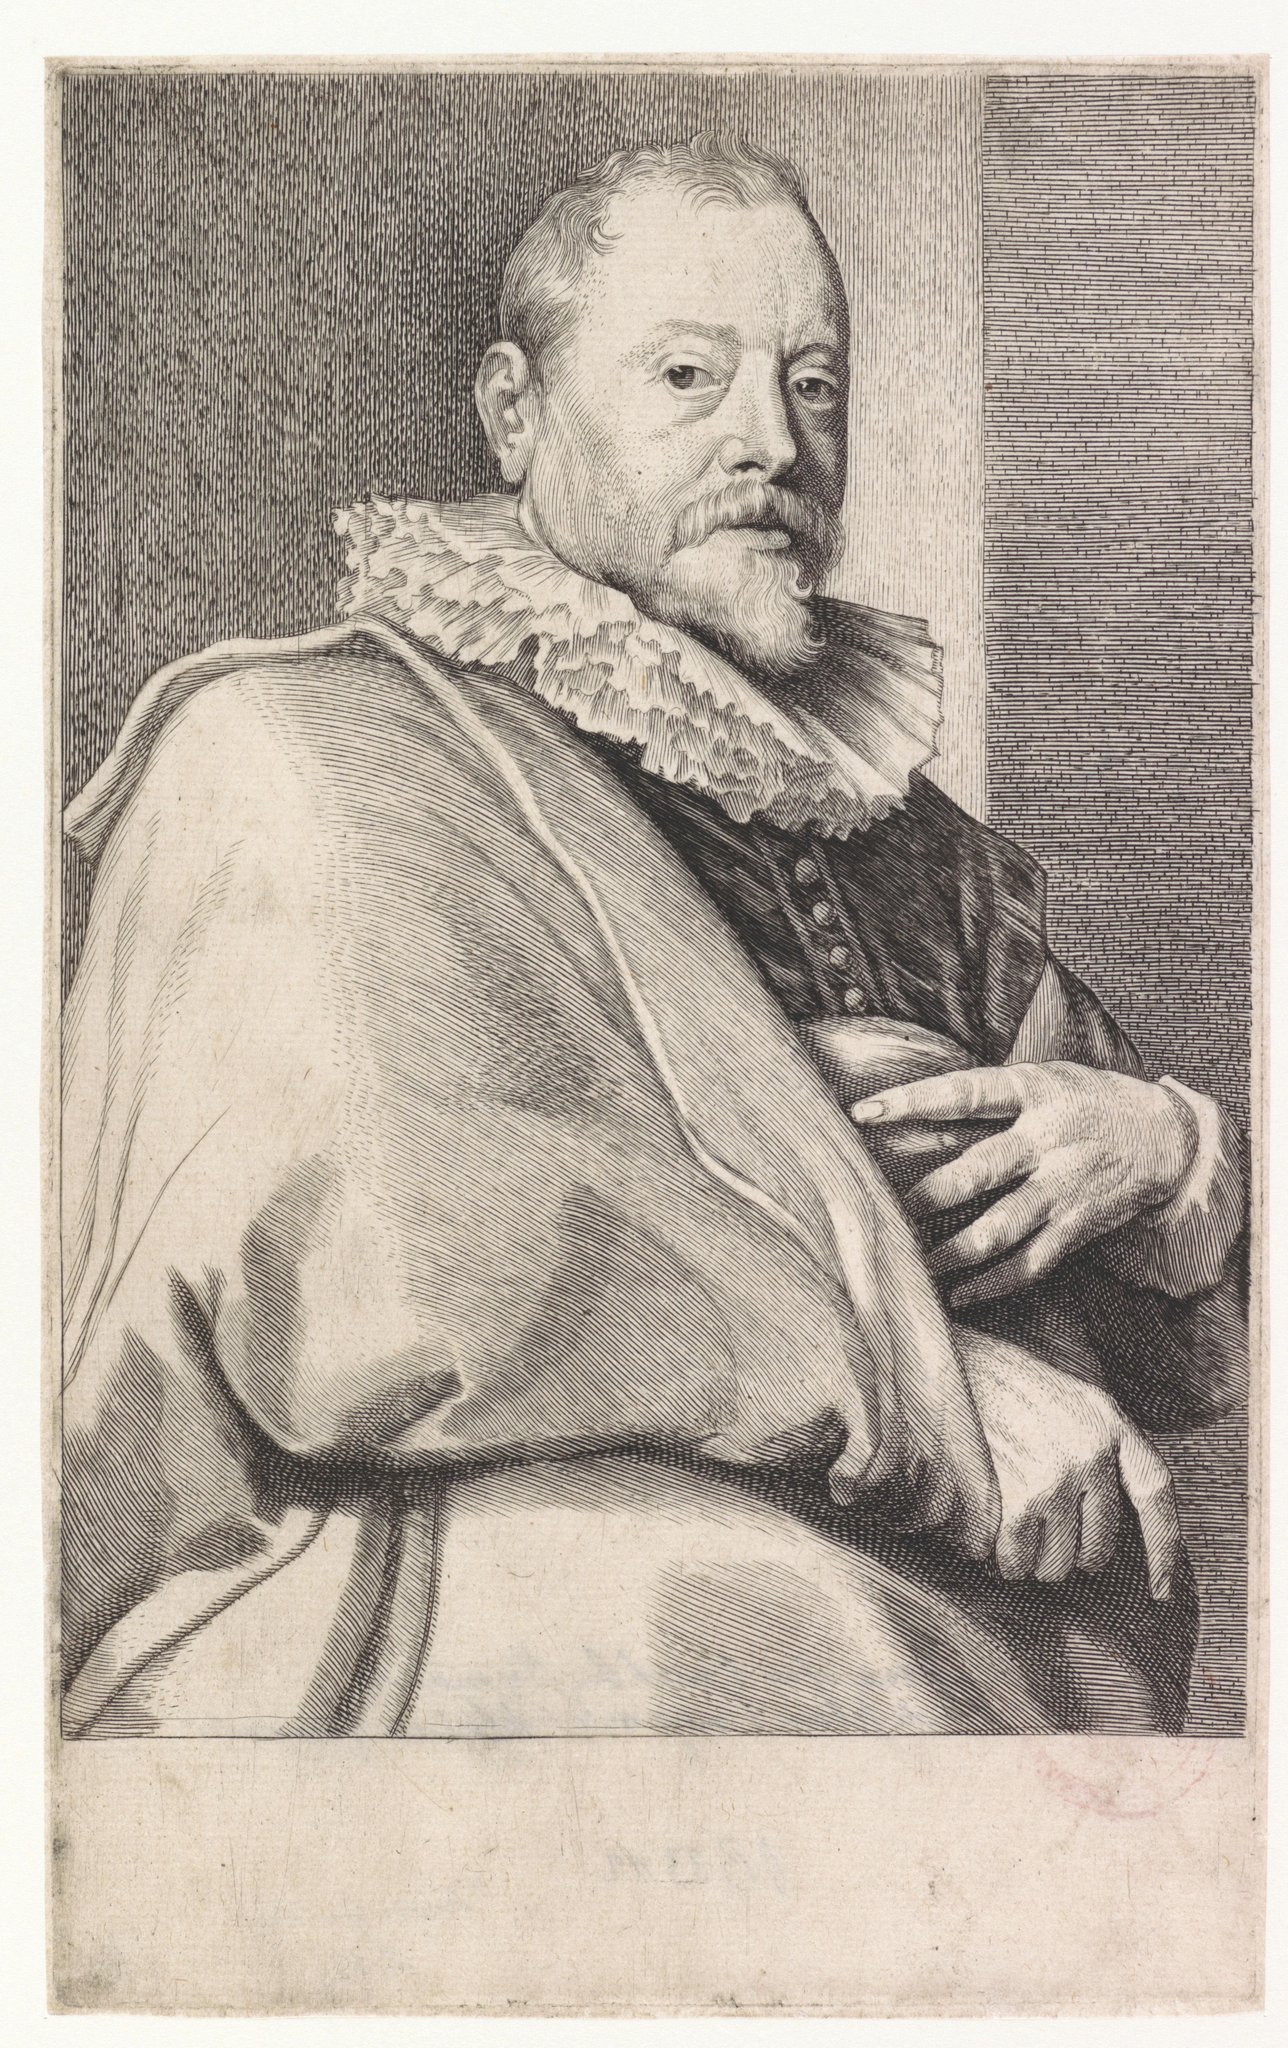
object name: print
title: Iconographie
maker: lucas vorsterman (i)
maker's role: print maker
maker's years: 1595-1675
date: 1630-1646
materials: paper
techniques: engraving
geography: antwerp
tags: theodoor galle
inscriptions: collector's mark: Lugt 240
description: Prent gebruikt voor: Icones principum, virorum doctorum, pictorum, chalcographorum, statuariorum nec non amatorum pictoriae artis numero centum ab Ant. van Dyck ad vivum expressae ejusque sumptibus aeri incisae. Antwerpen: Gillis Hendricx, [1645-1646].